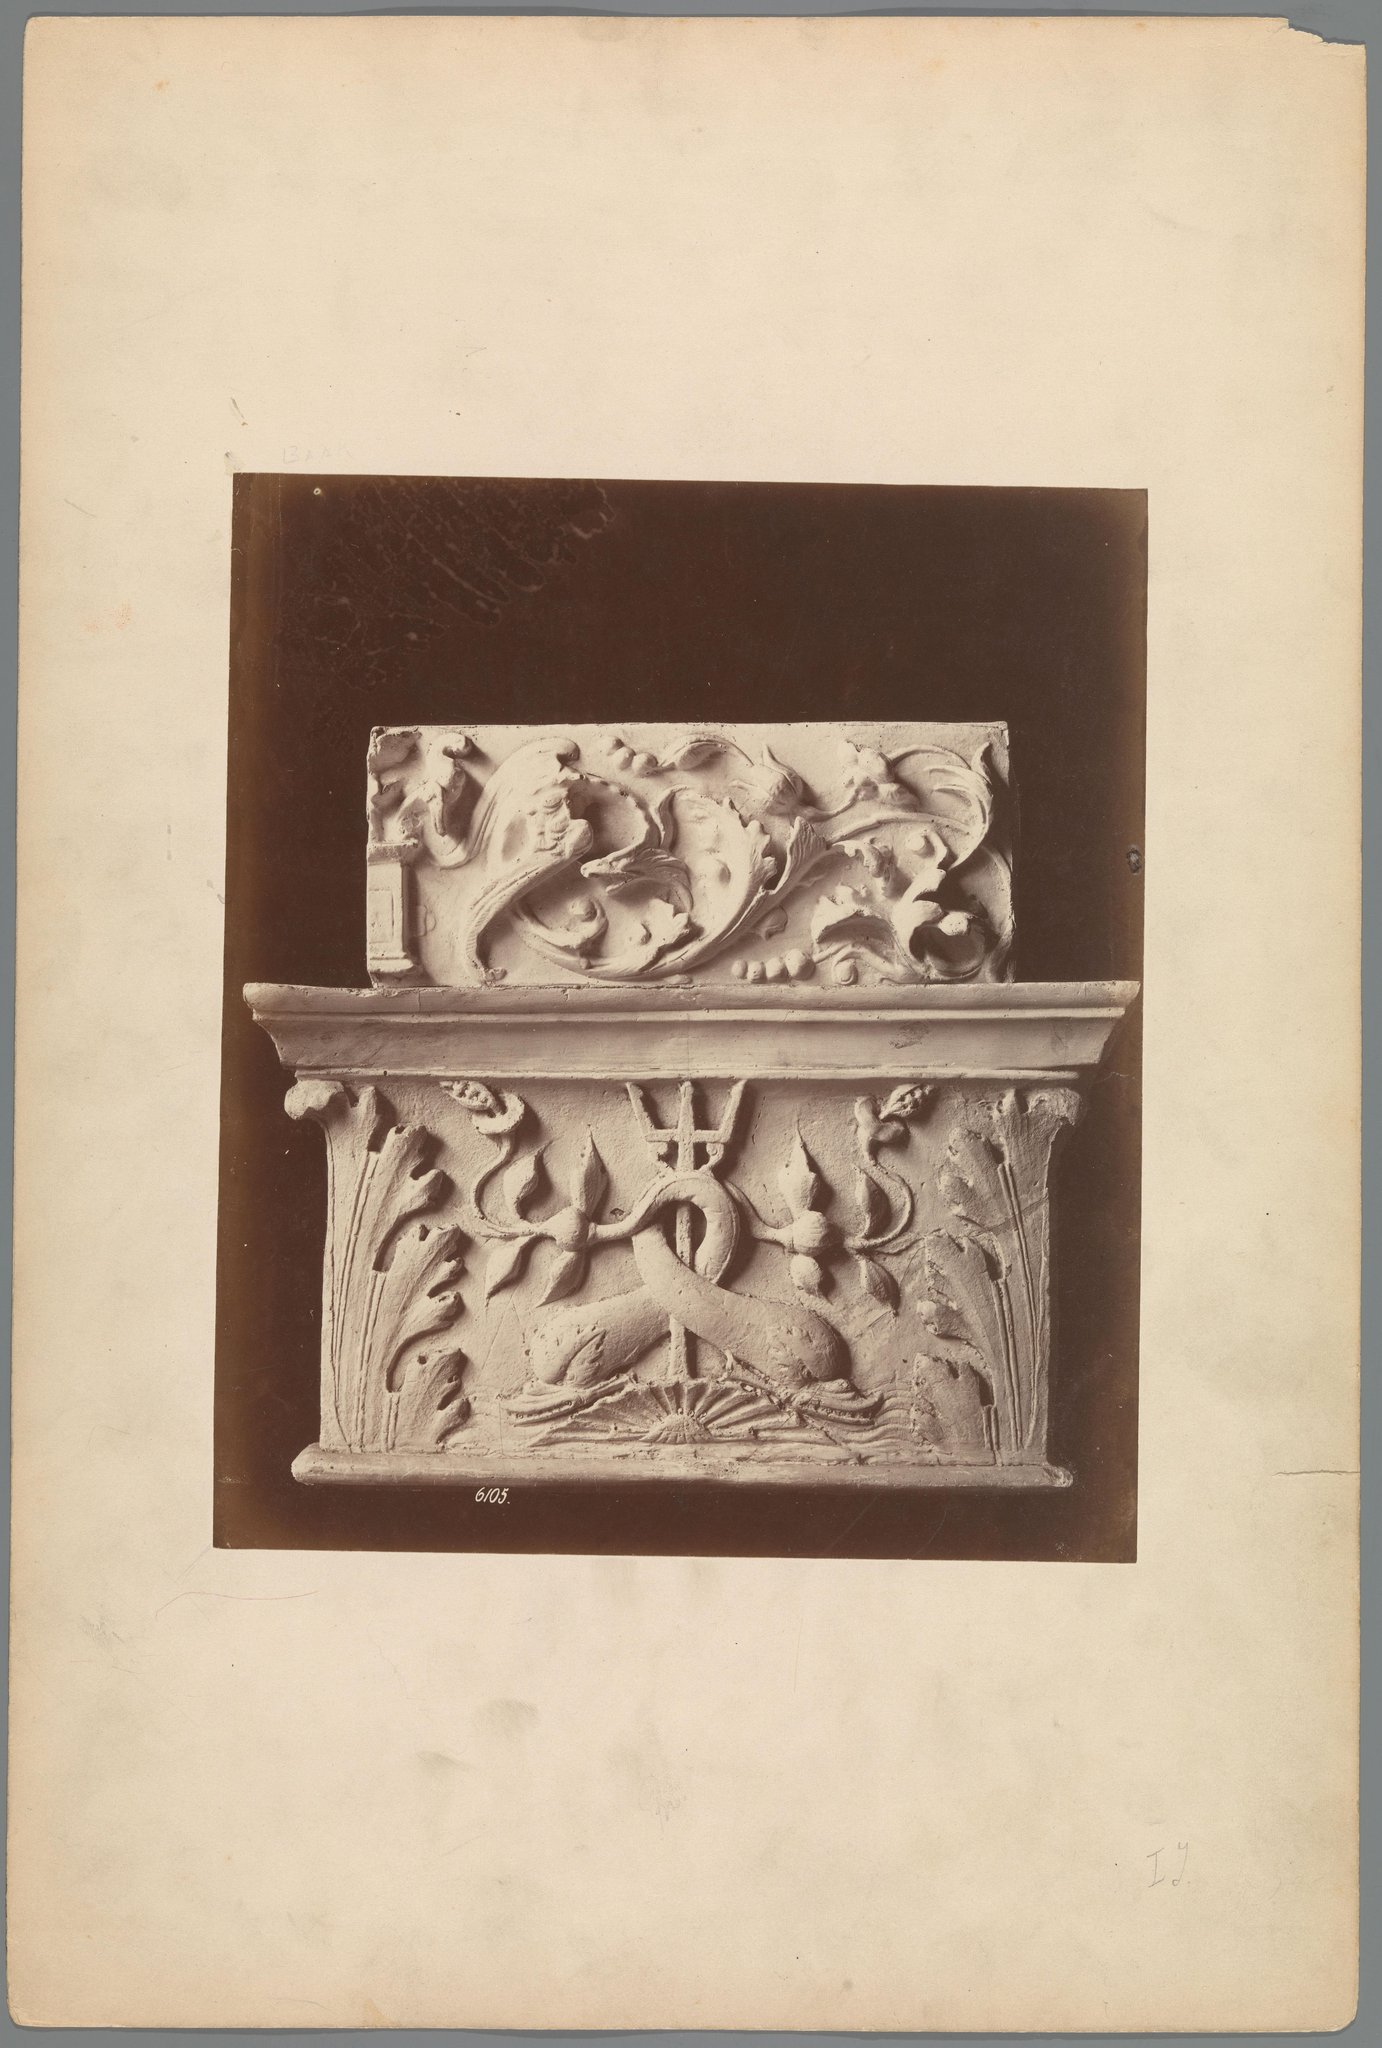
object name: photograph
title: Kapiteel met acanthusbladeren en twee dolfijnen rond een drietand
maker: Anonymous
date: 1875-1900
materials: cardboard, photographic support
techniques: albumen print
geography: europe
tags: dolphin ~ ornament, acanthus ~ ornament, attributes of neptune: trident, sculpture (+ relief ~ sculpture), europe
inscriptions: number: ‘6105.’, collector's mark: Lugt 3937